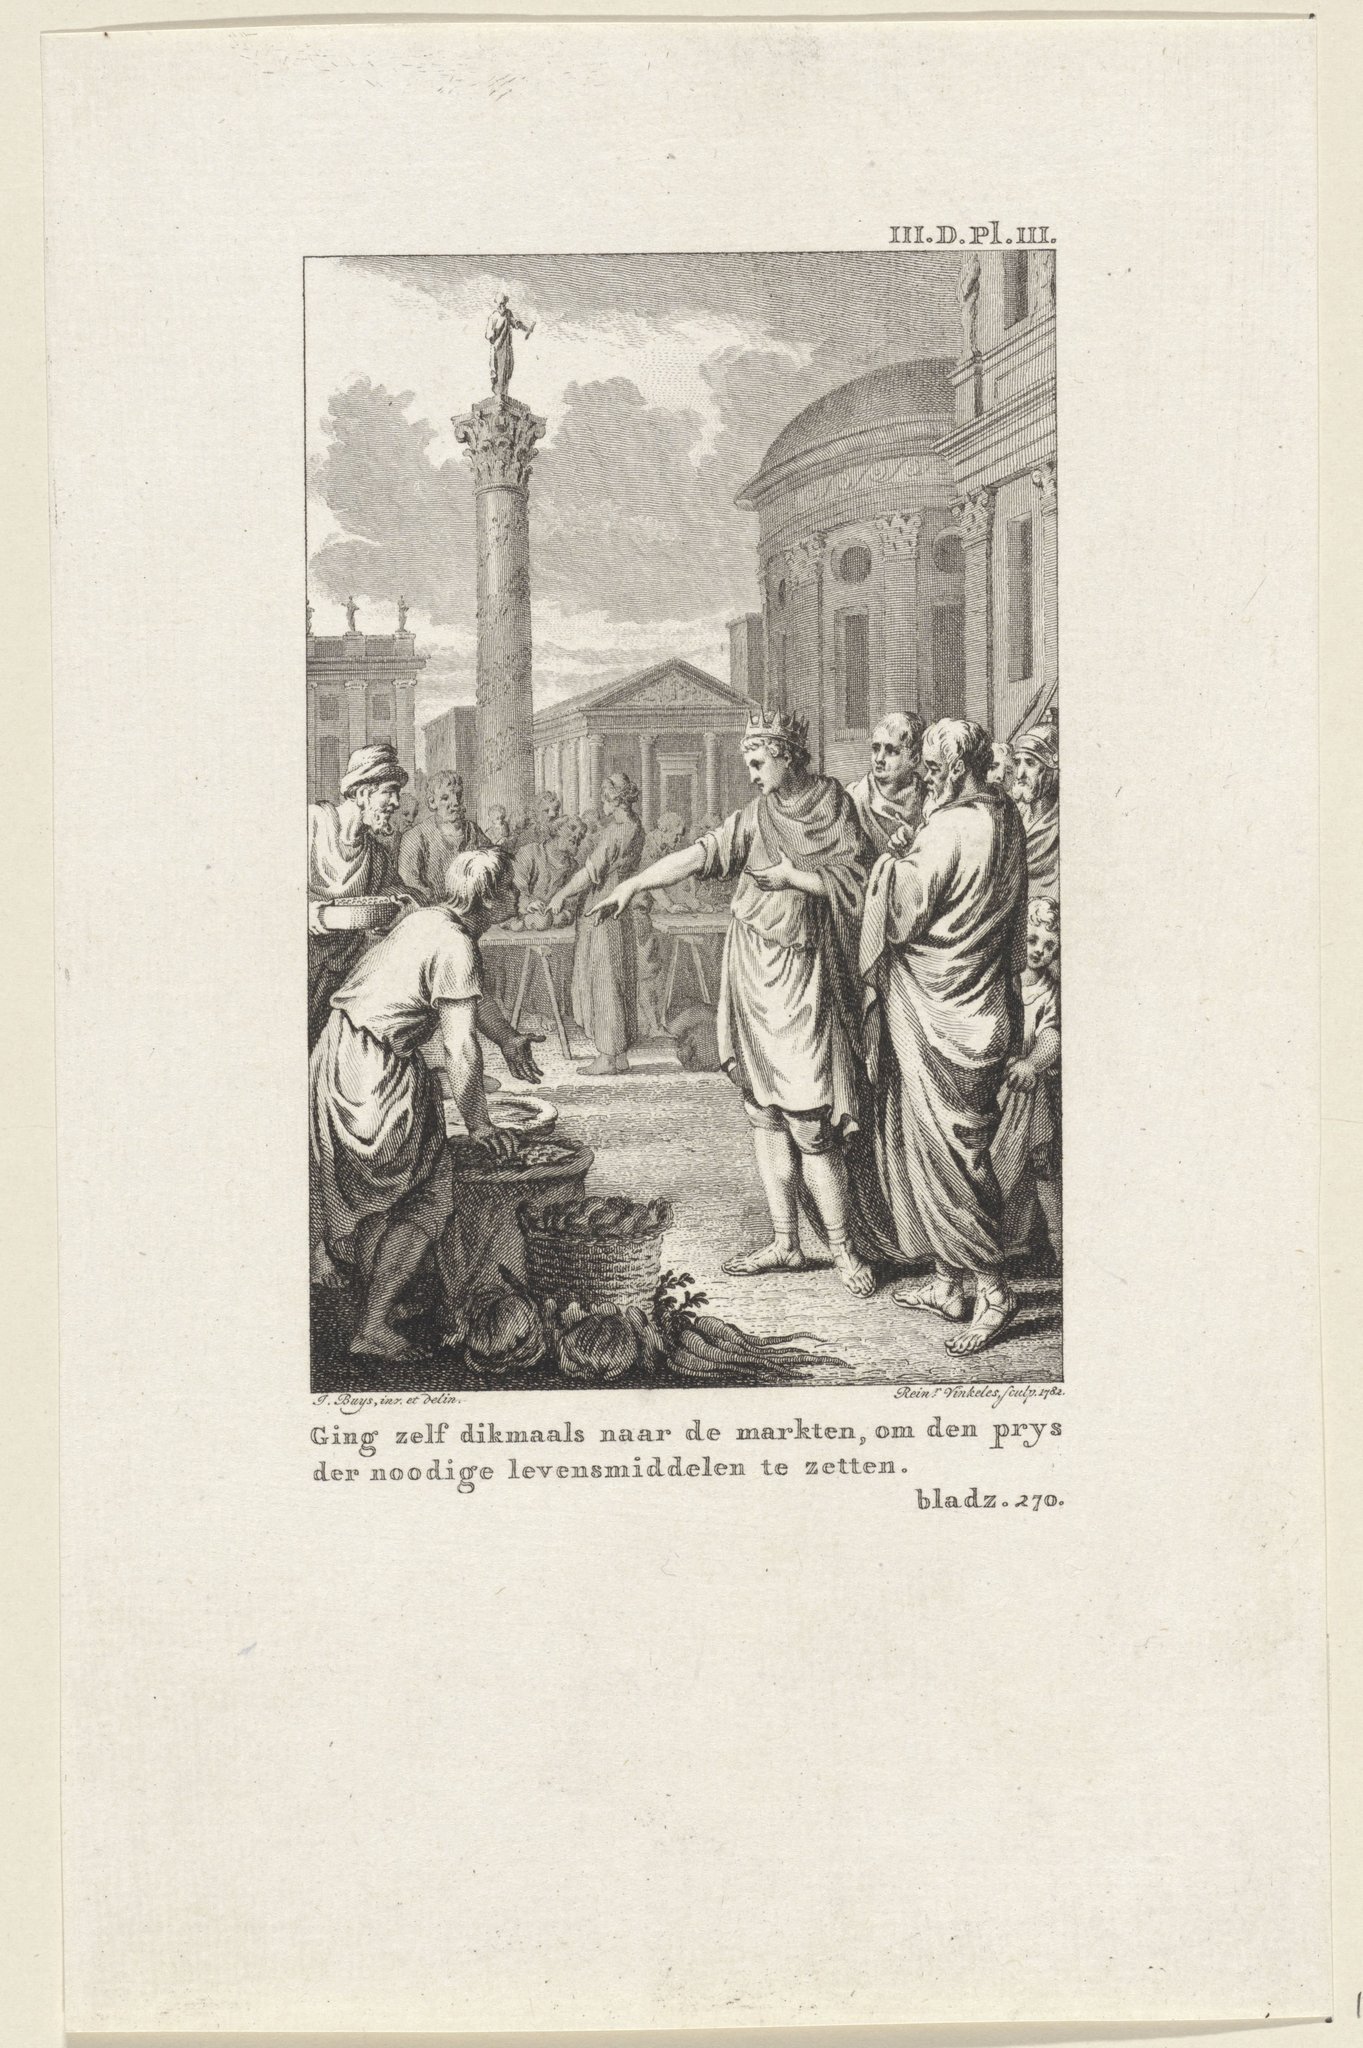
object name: print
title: Theophilos van Byzantium op een markt in Constantinopel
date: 1782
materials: paper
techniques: engraving, etching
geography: amsterdam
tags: market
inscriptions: collector's mark: Lugt 240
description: Prent gebruikt als boekillustratie in: Martinet, Joannes Florentius. Historie der waereld. Amsterdam: Johannes Allart, 1780-1788. 25 delen. deel III, pl. III.